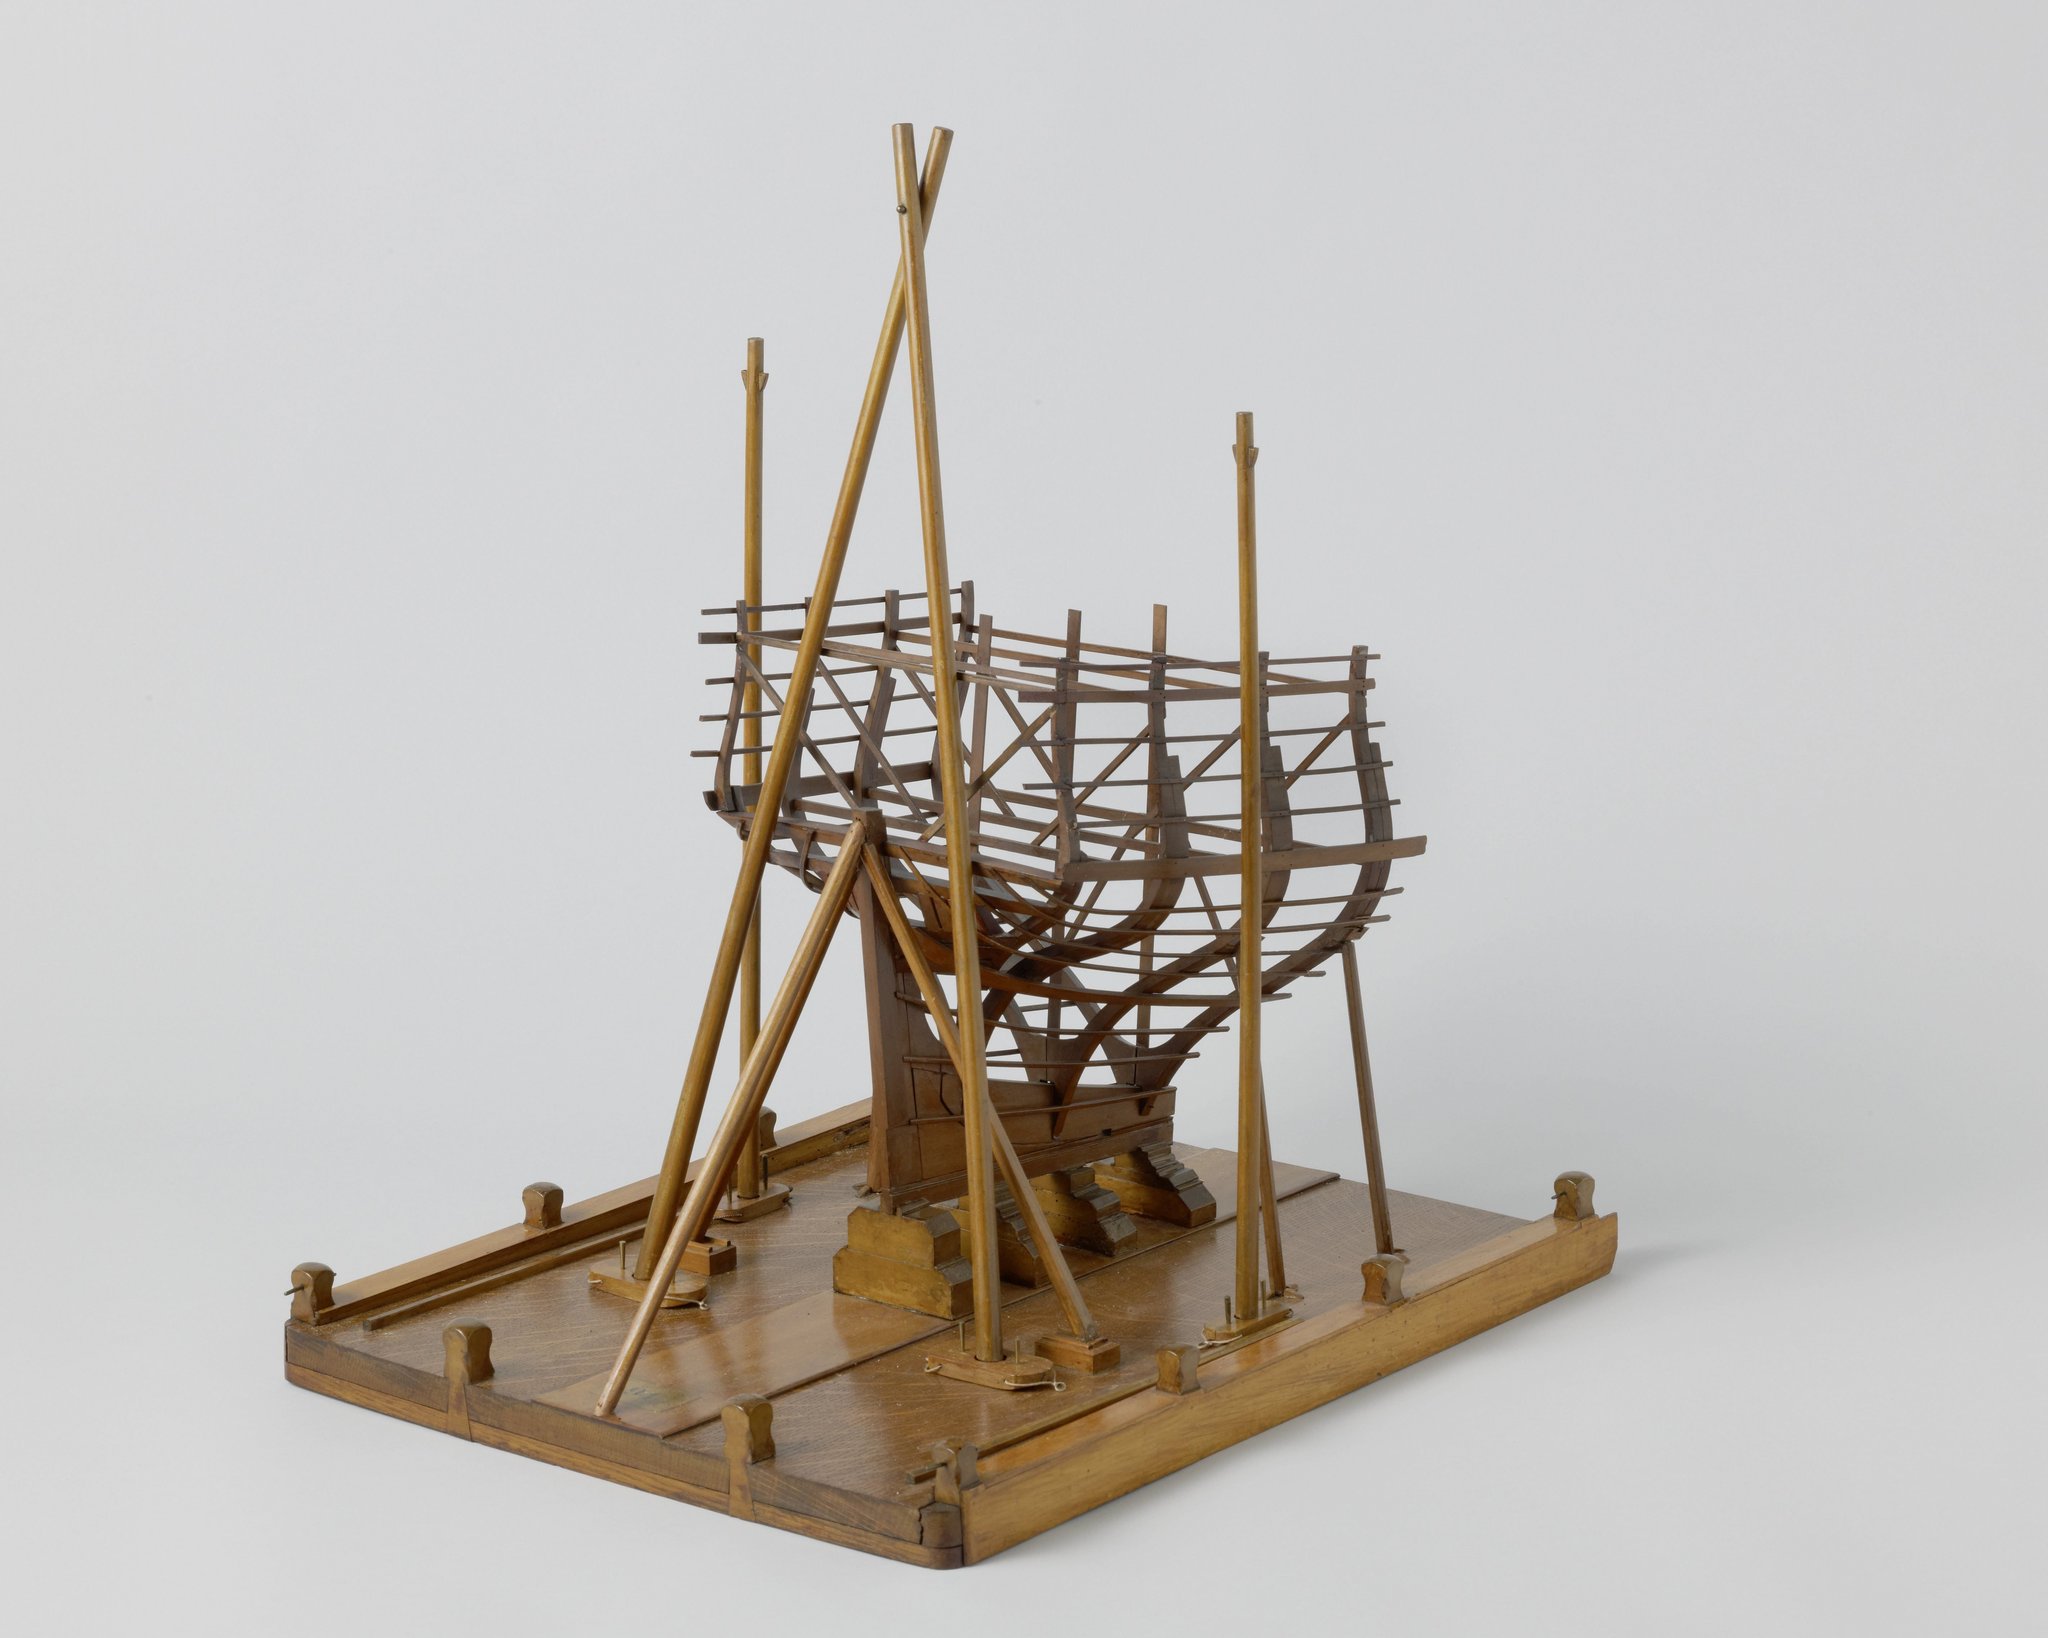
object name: demonstration model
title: Model of a Ship's Stern in Construction on a Shipyard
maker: Anonymous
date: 1750-1825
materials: wood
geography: netherlands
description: Constructiemodel van een achterschip in aanbouw op een werf, op een grondplank. Het is een spantmodel met senten op stapelblokken. Gewrongen spiegel met vier worpen en acht korte achterapostelen tussen de bovenste twee worpen, waarvan er zes ontbreken. Geen wulf, hek of zijgalerijen. Het model heeft drie spanten van oprichting, alle steekspanten waarvan de korte stekers ontbreken, en zwevende rantsoenhouten. Vier stutten en de hijspalen voor de achtersteven zijn gevonden; twee steunen en de hijspalen staan op platte ovale onderleggers. Op de zijden van de grondplank tien stoppers.